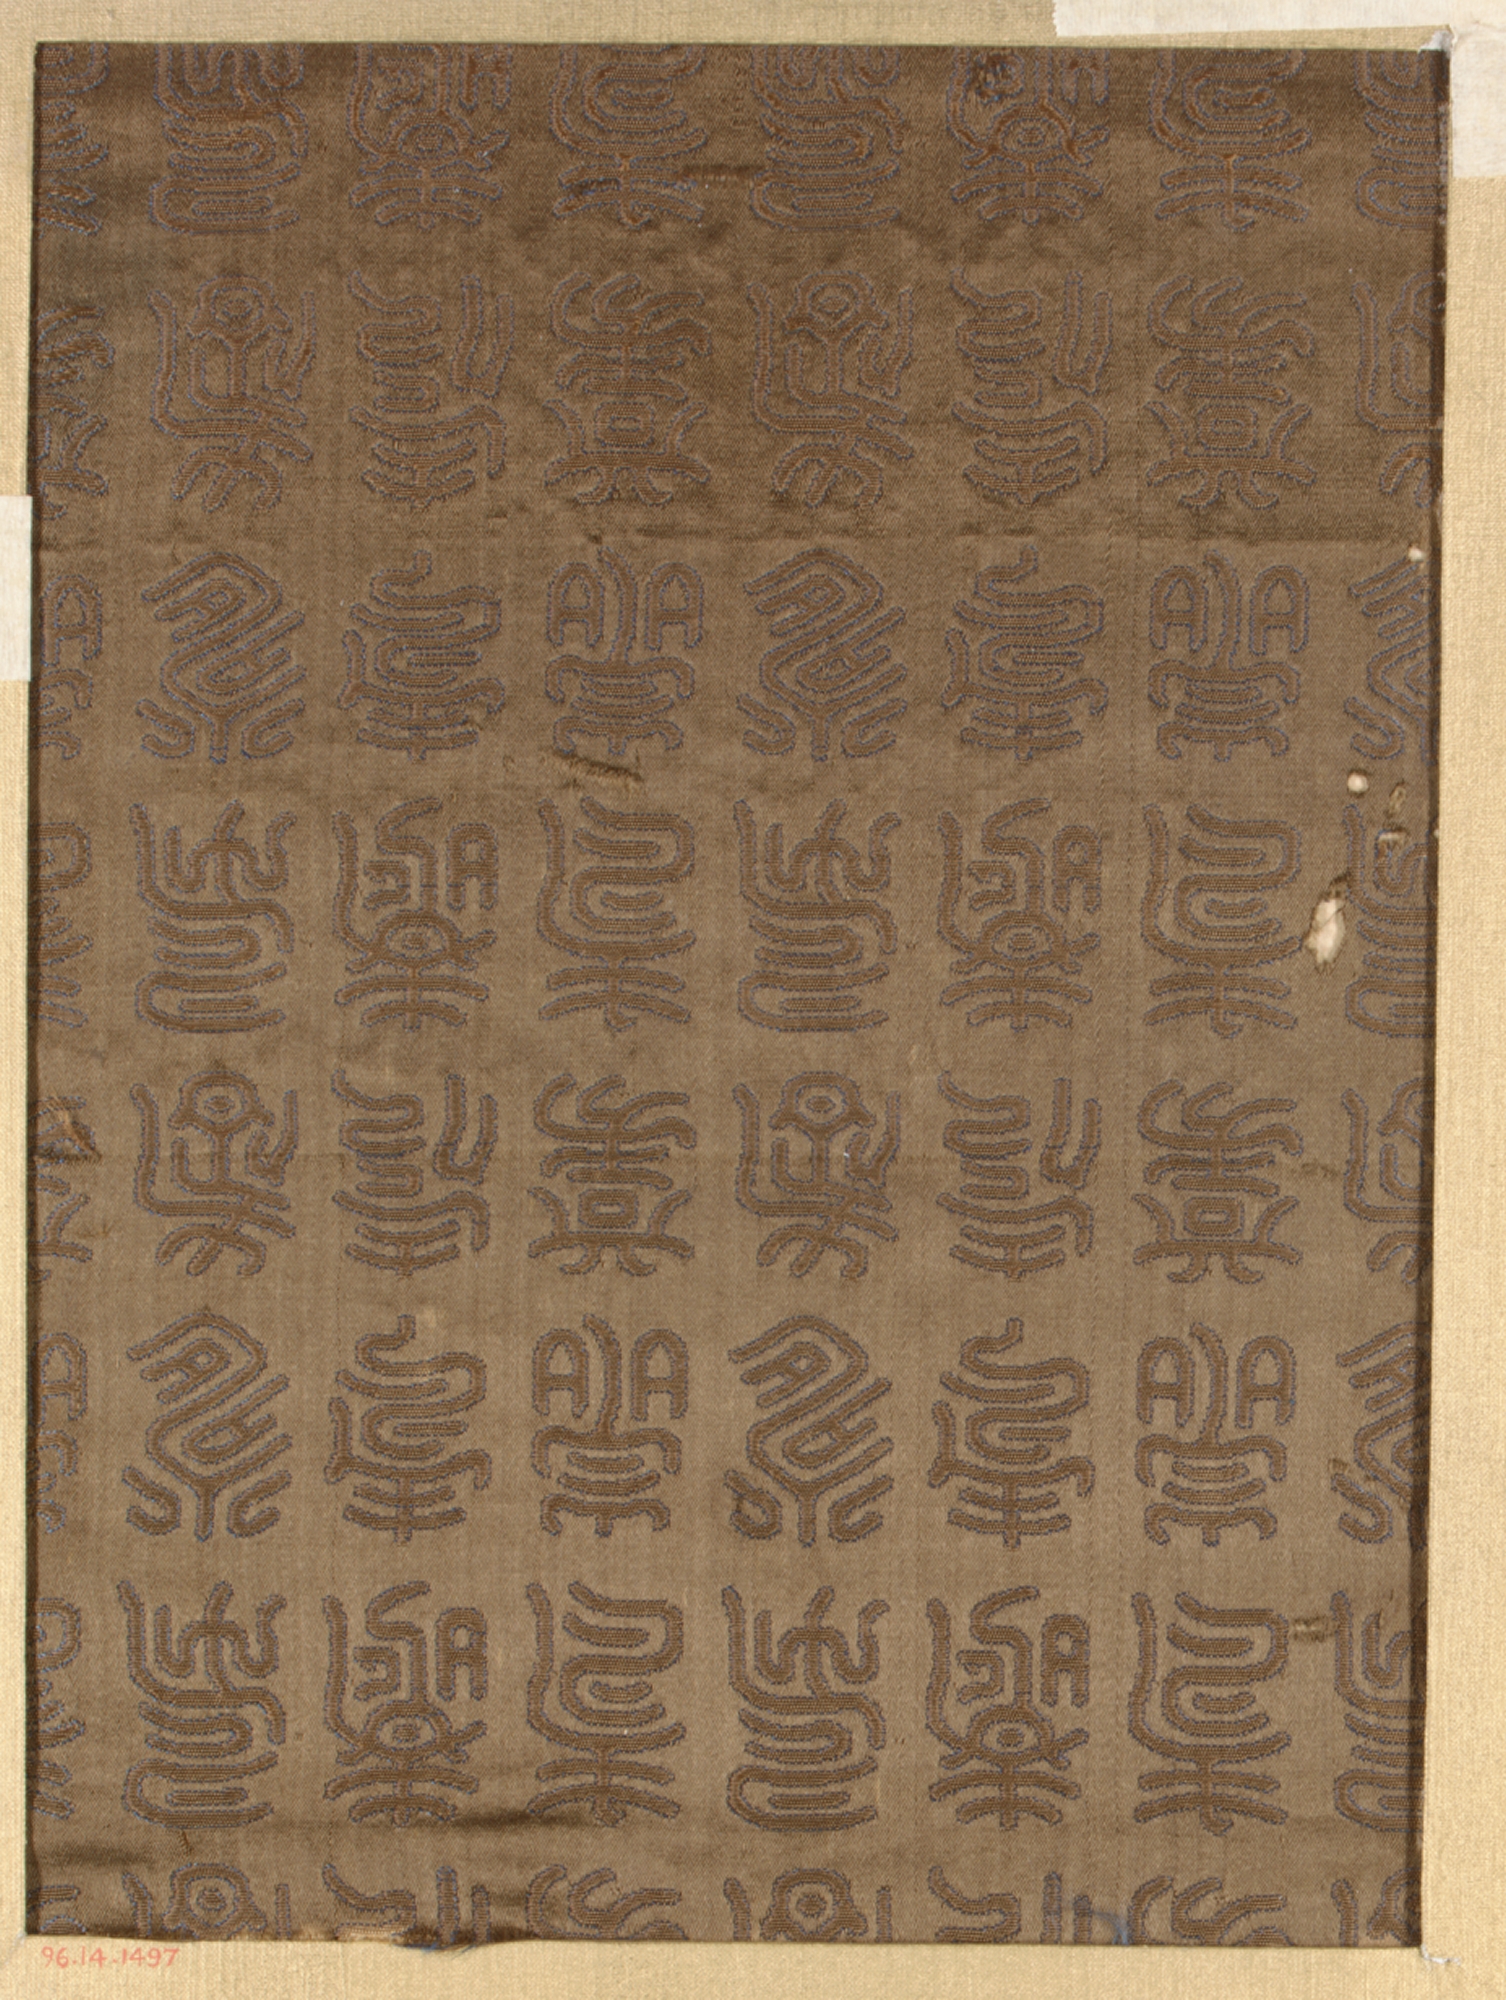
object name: piece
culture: japanese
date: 1701-1900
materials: silk